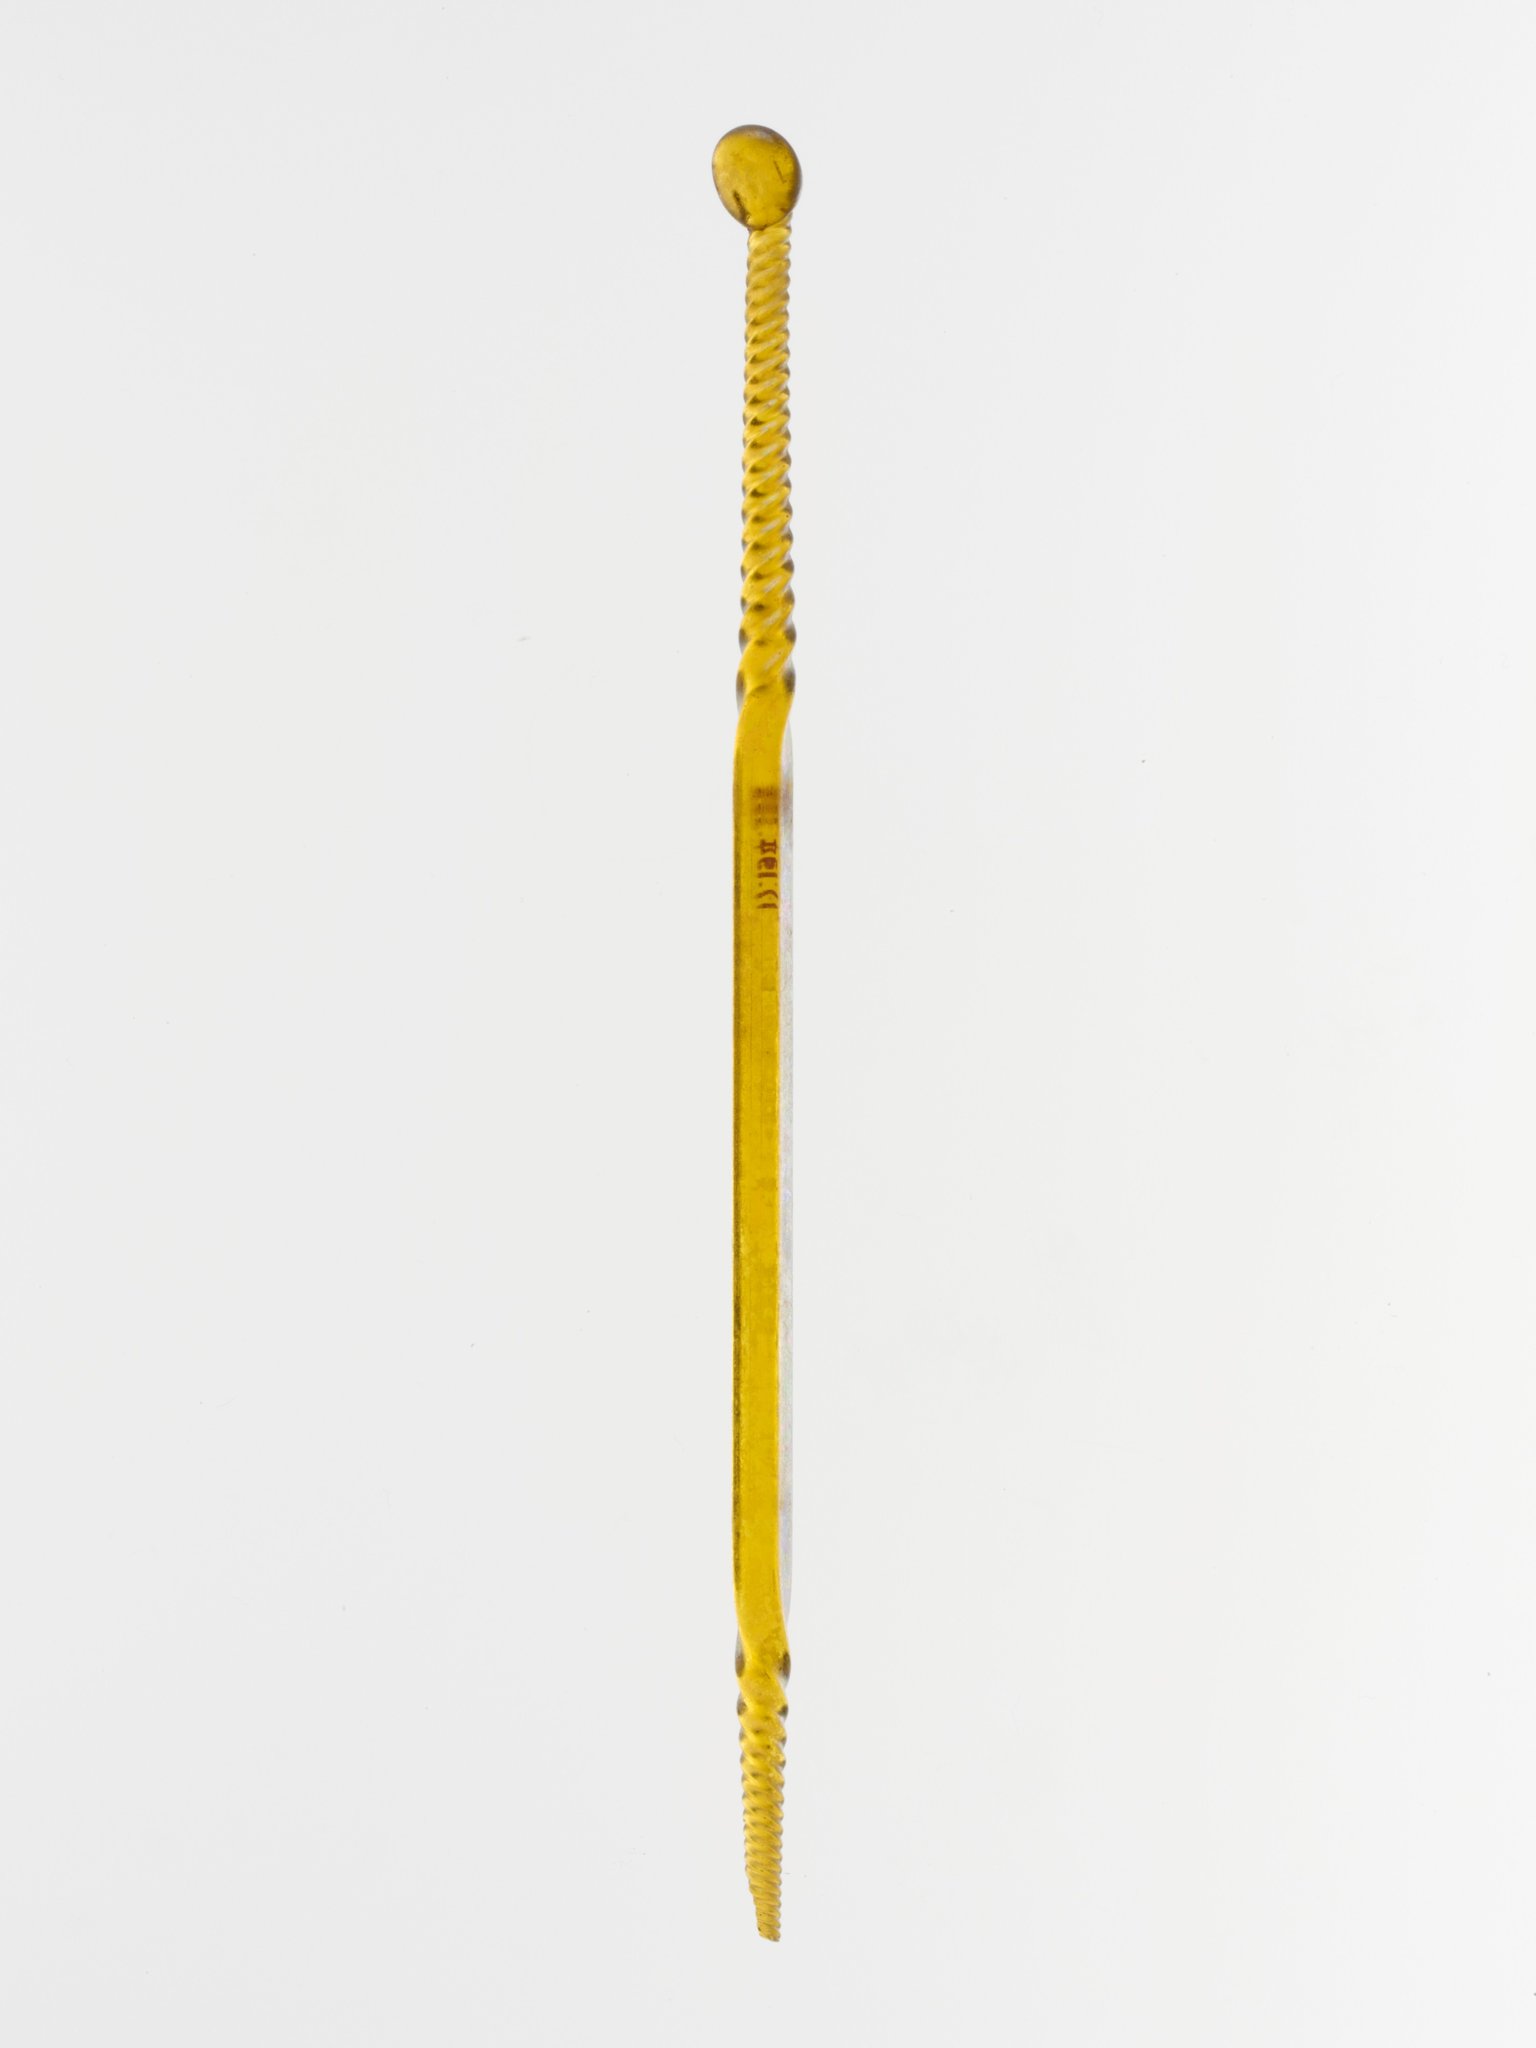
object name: cosmetic spoon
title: Glass ligula (ear pick)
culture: roman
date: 1-100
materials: glass